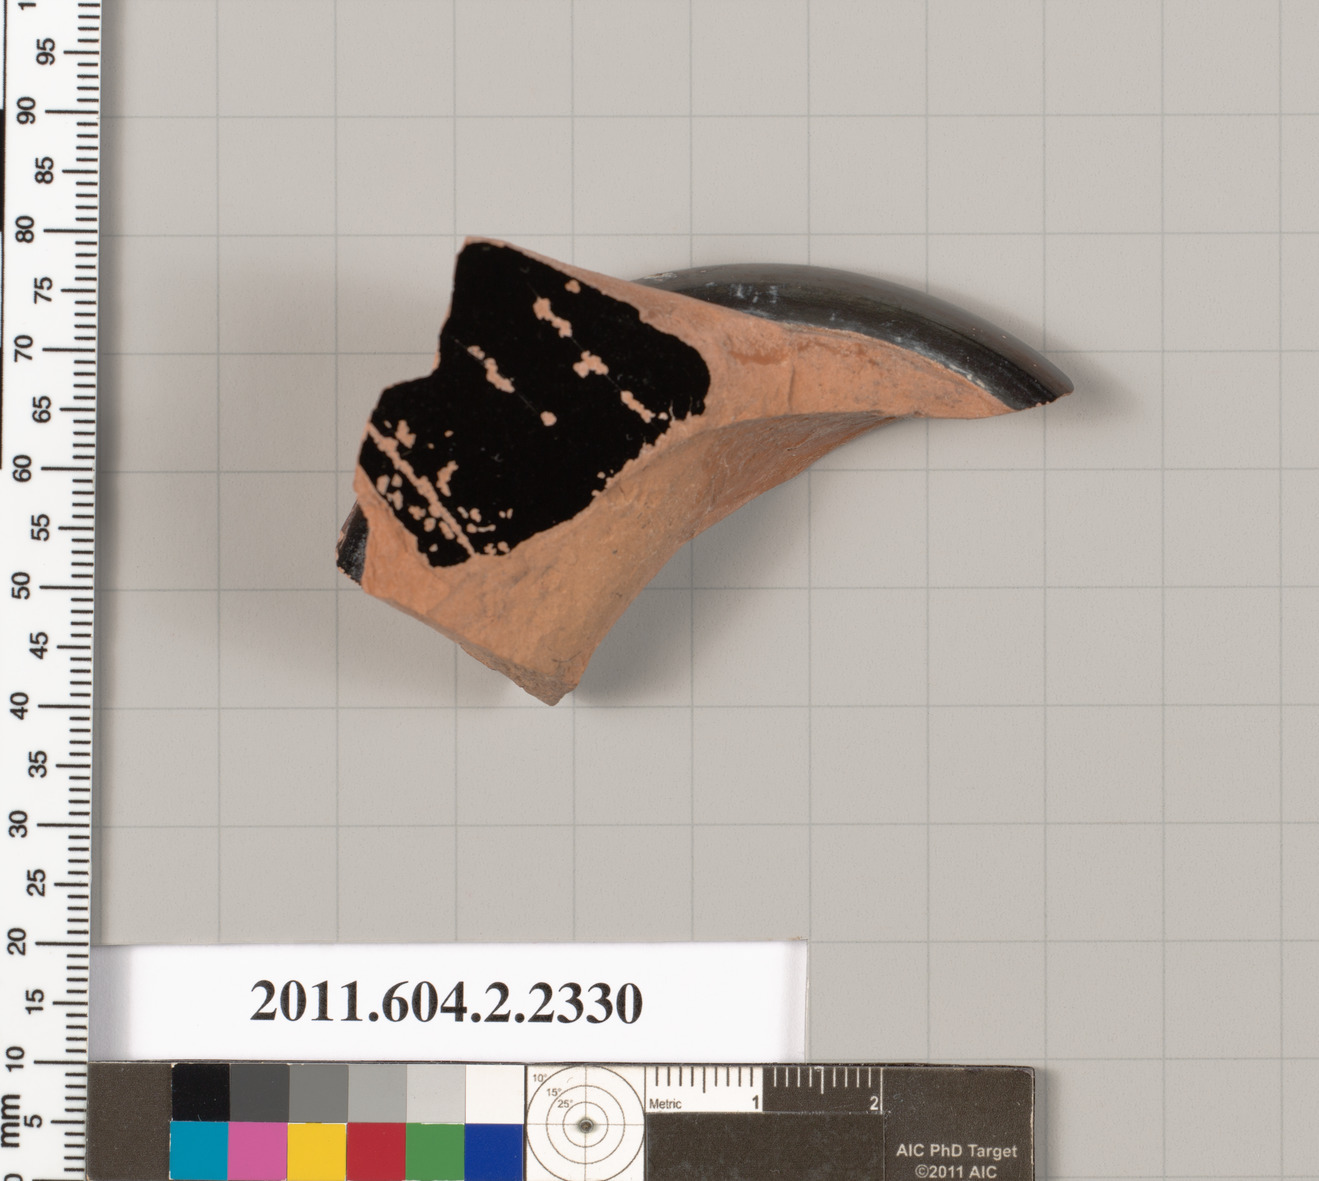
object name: skyphos fragment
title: Terracotta fragment of a skyphos (deep drinking cup)?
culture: greek, attic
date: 475-451 BCE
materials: terracotta